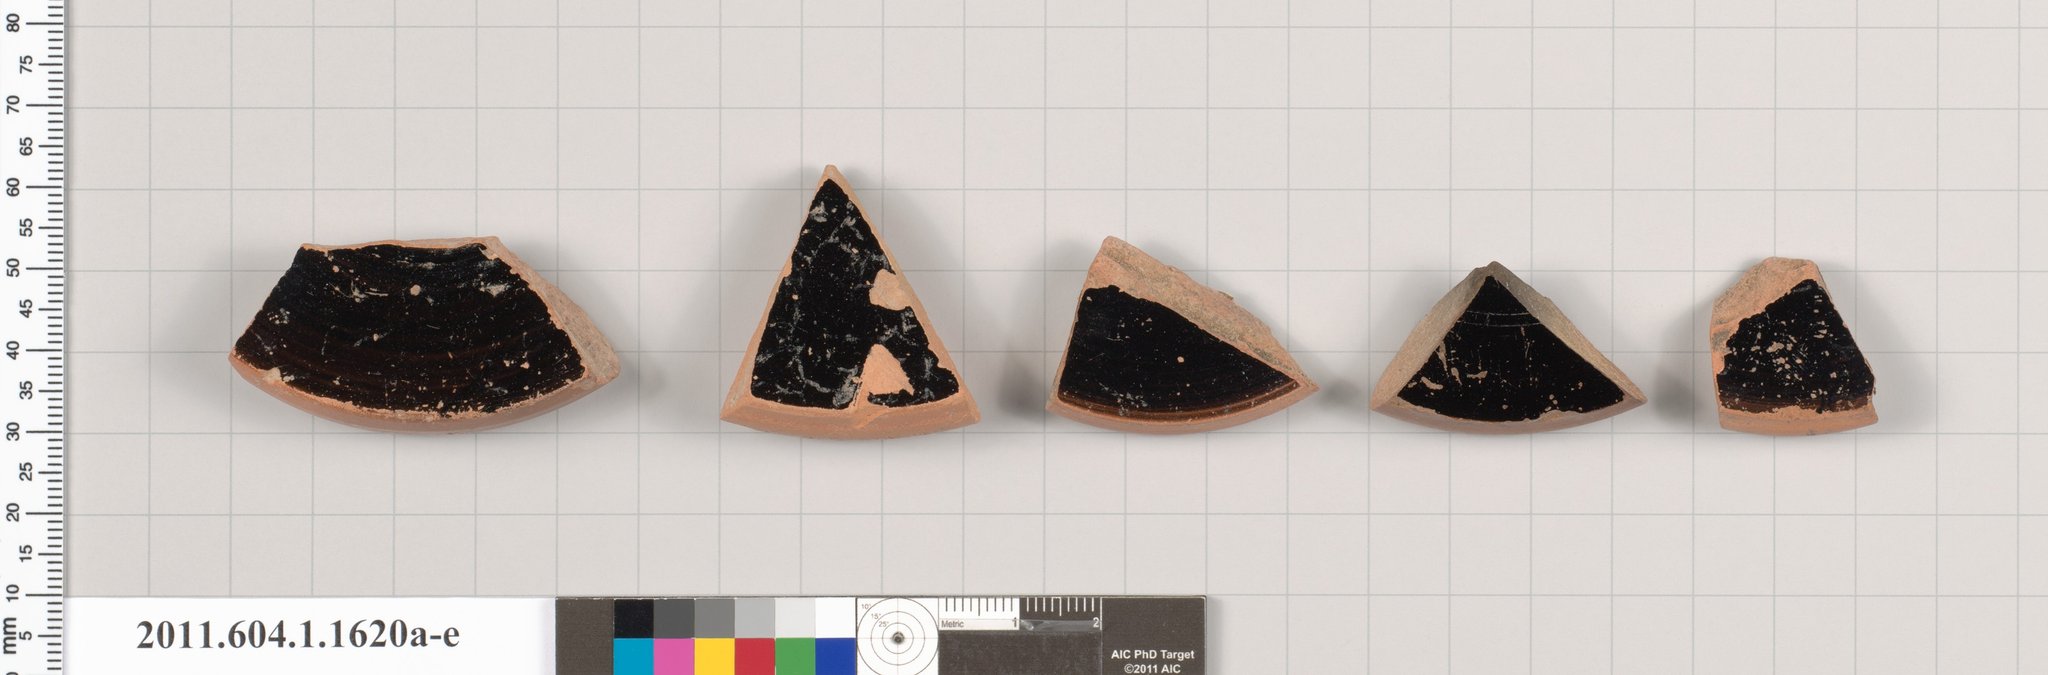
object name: kylix fragment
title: Terracotta fragments of kylikes (drinking cups)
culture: greek, attic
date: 500-401 BCE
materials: terracotta